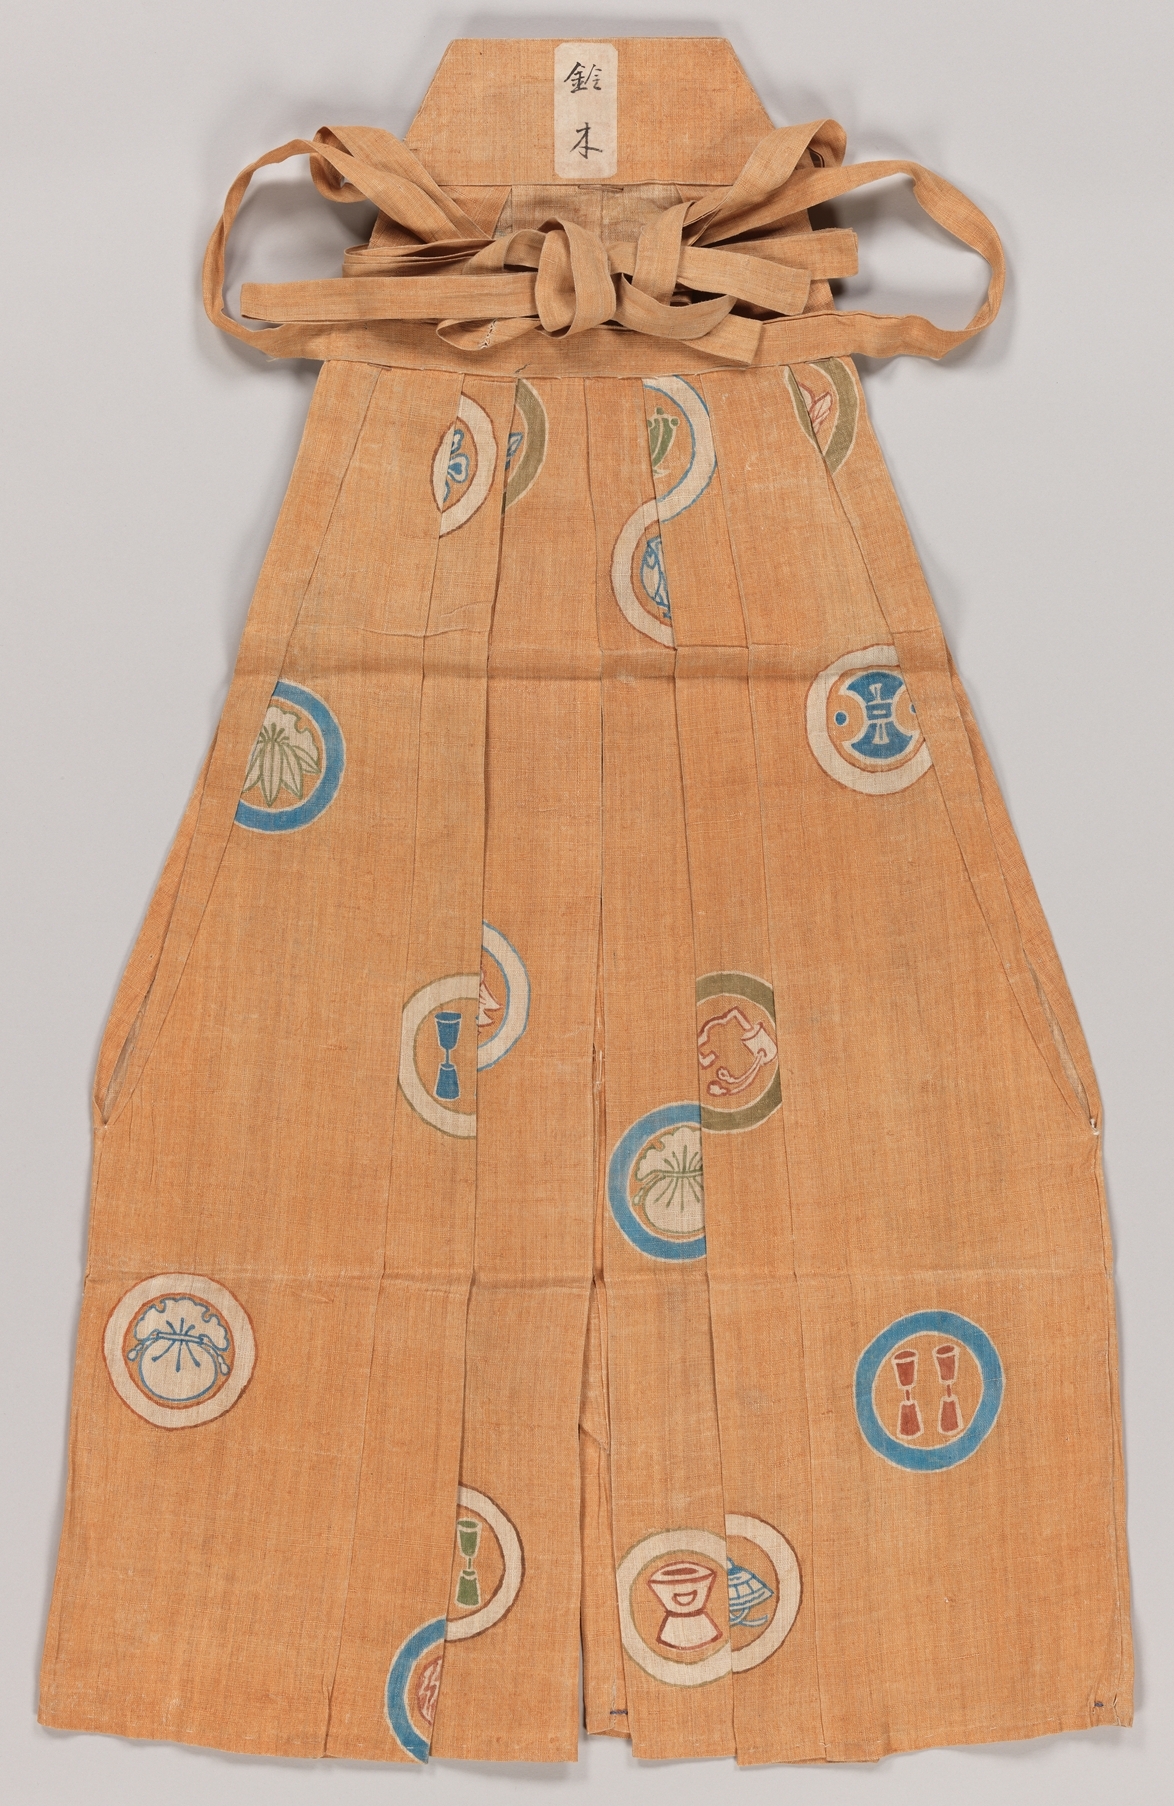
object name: trouser for kyōgen theatre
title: Trousers for kyōgen theatre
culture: japanese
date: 1801-1900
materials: fiber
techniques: dyeing, painting, weave, resist